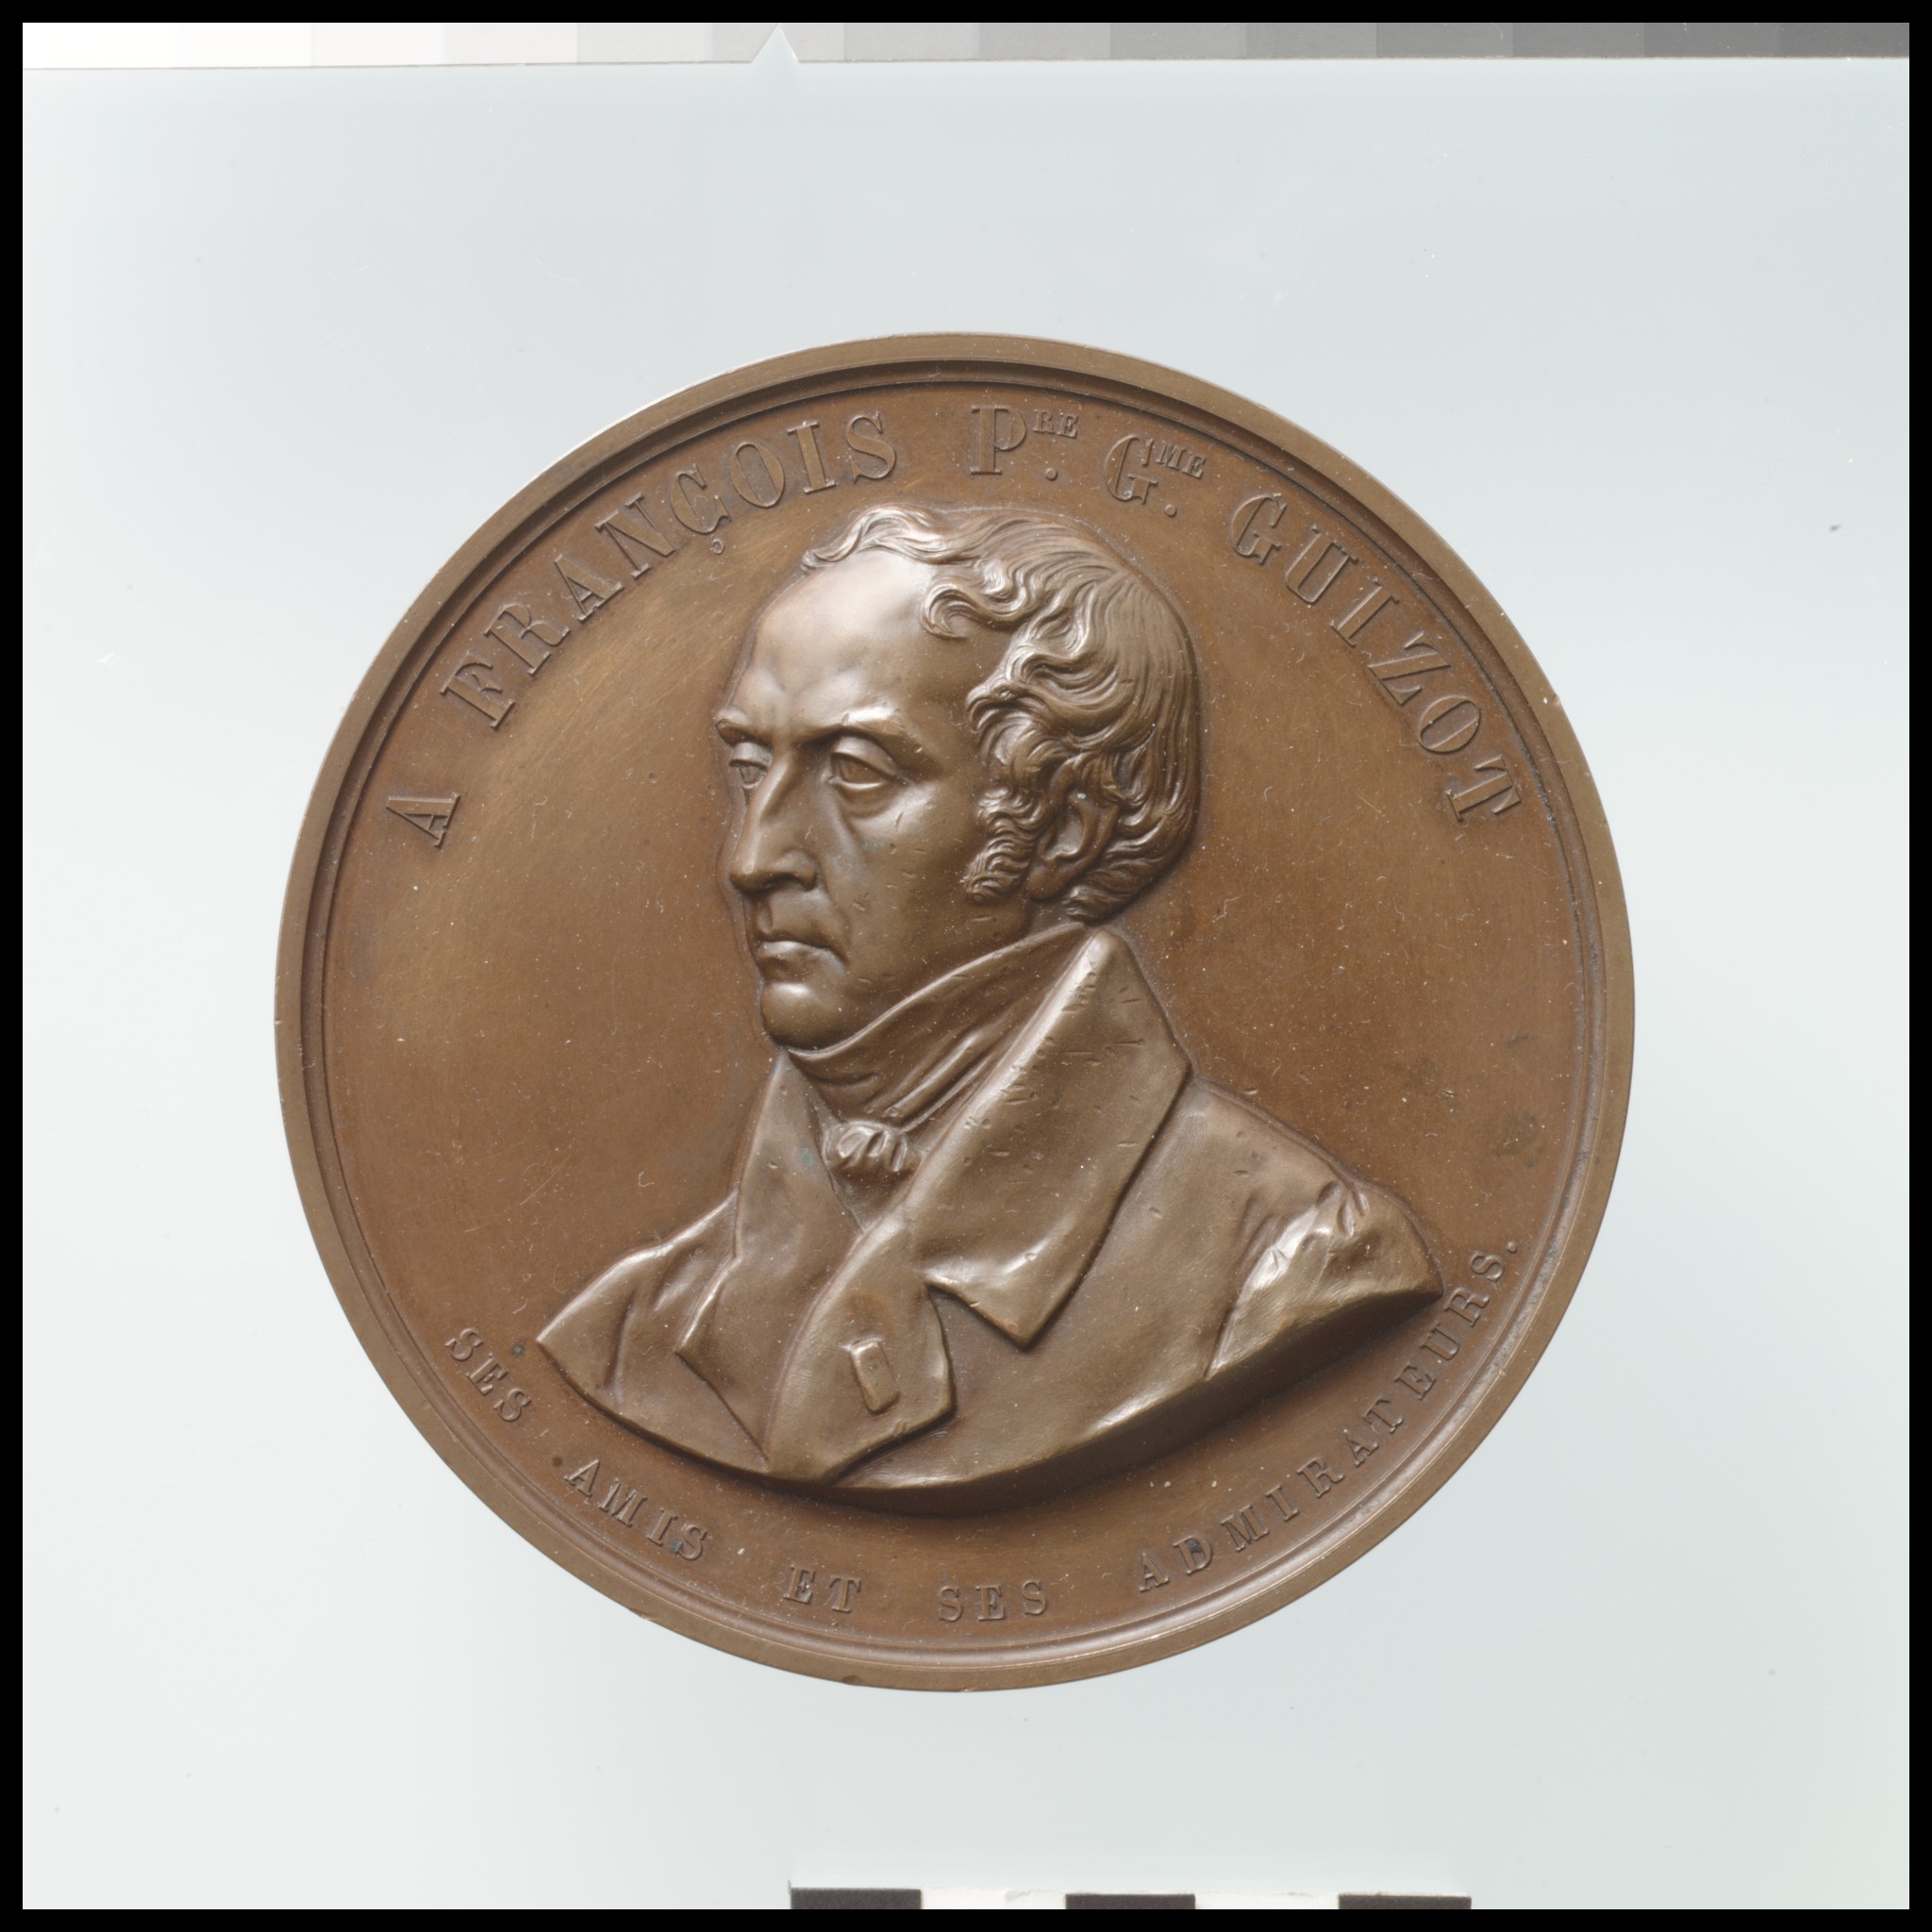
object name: medal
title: François Pierre Guillaume Guizot (1787–1874)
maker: jean-jacques feuchère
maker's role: artist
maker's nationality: french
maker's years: 1807-1852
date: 1844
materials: bronze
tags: men,portraits